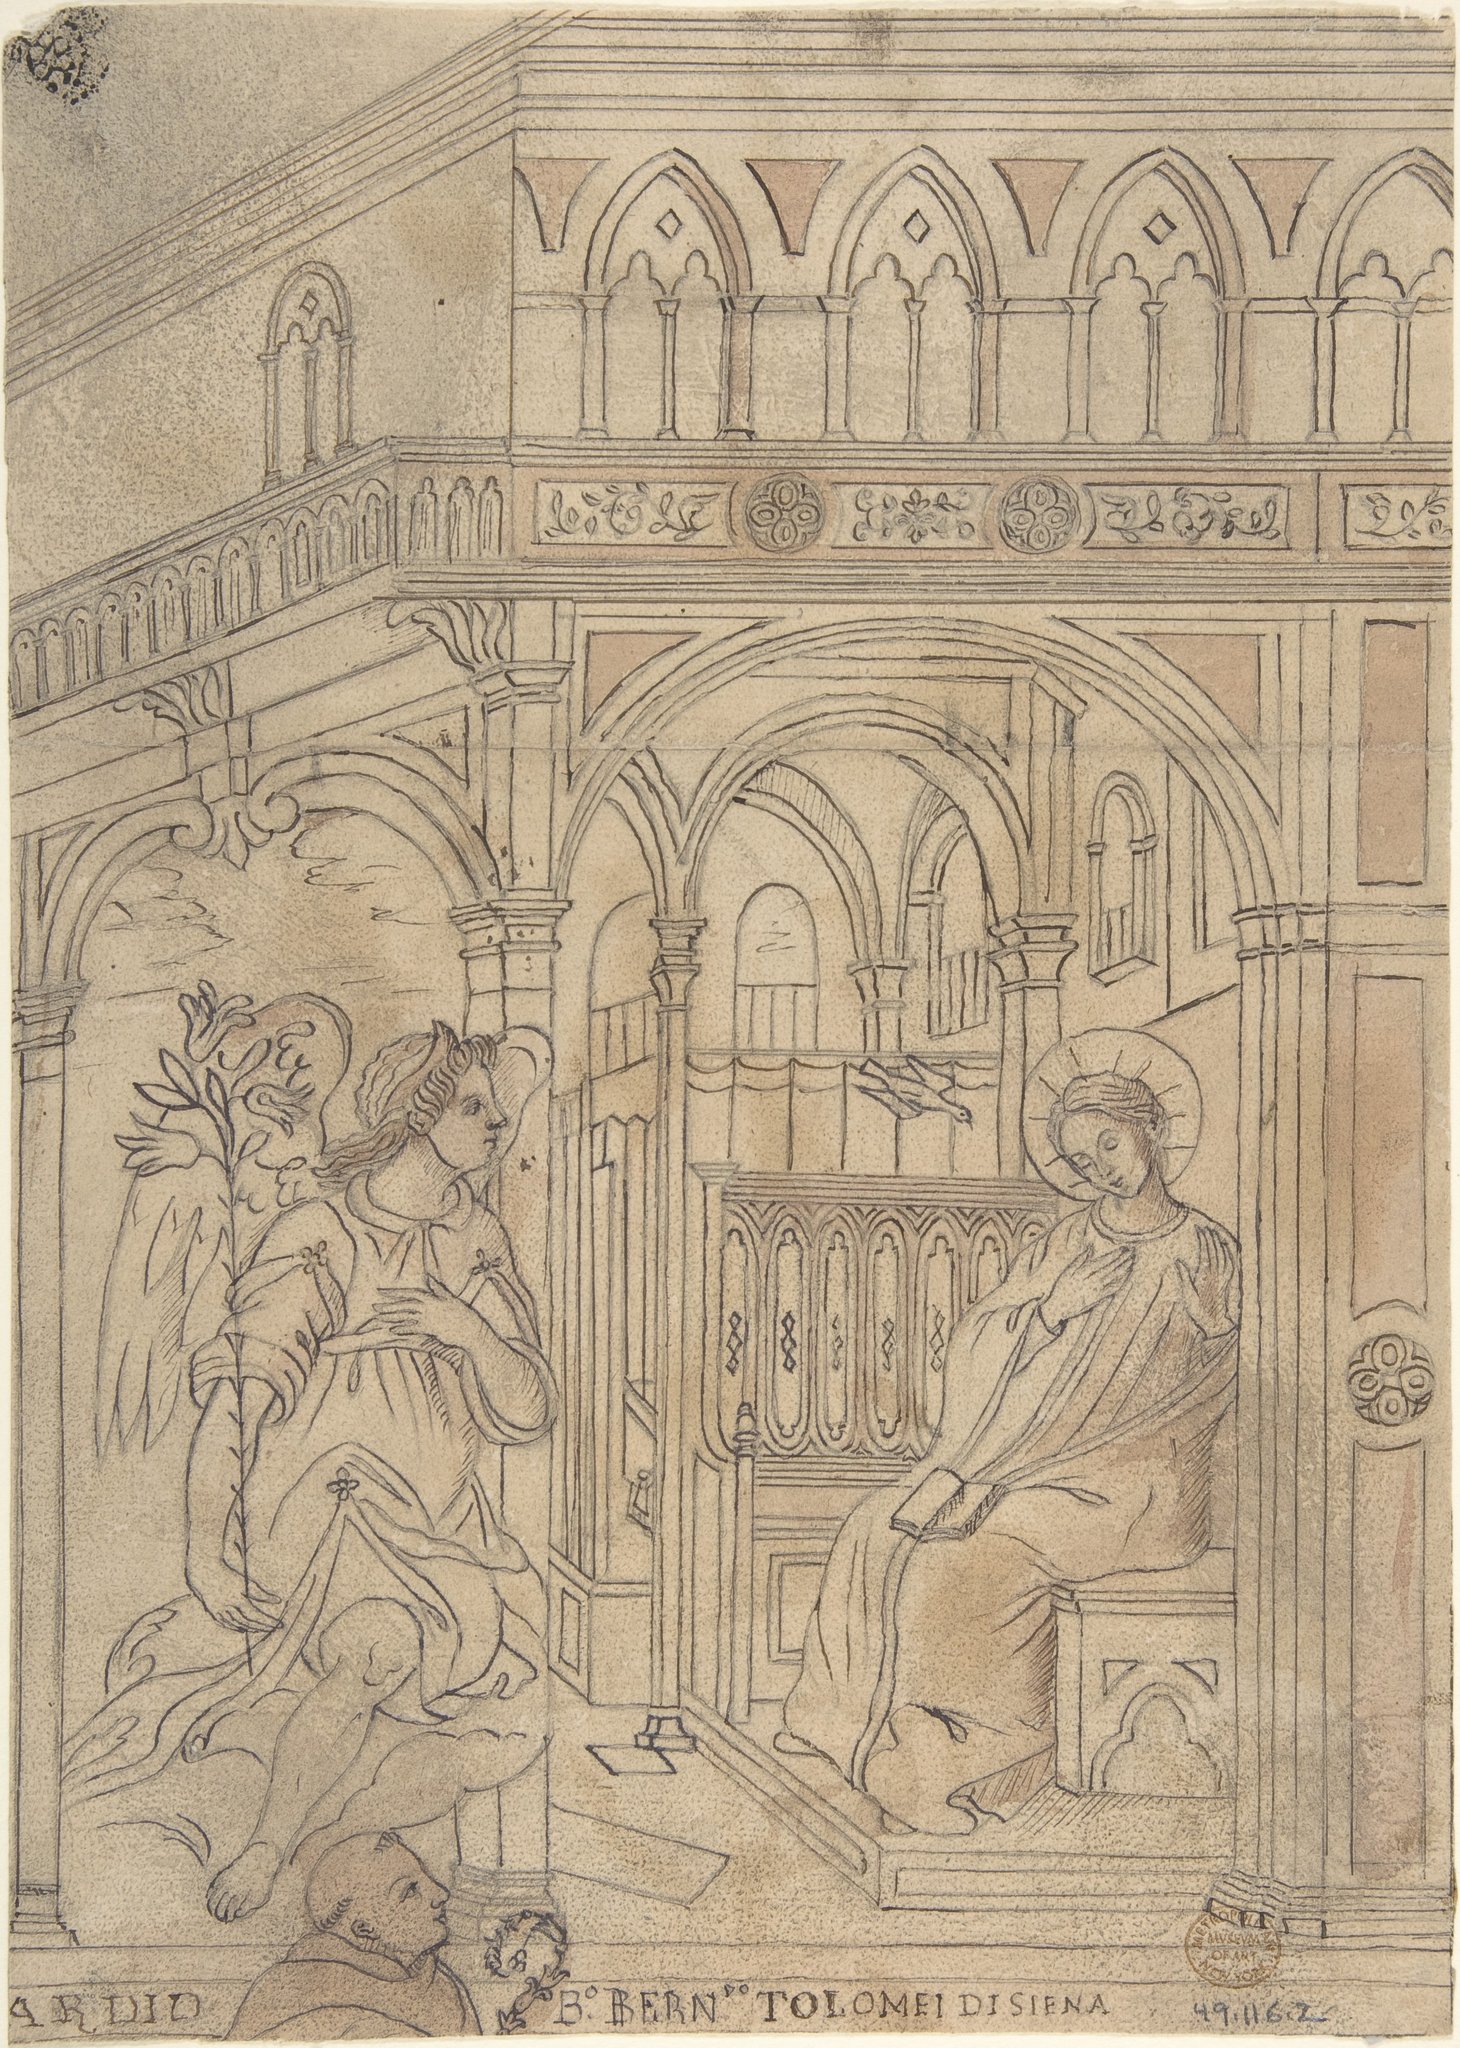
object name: drawing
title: Annunciation with Beato Bernardo Tolomei di Siena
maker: anonymous, italian, 19th century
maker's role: artist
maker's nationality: italian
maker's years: 1800-1900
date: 1801-1900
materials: chalk, graphite, ink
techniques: brush, incising, pen, wash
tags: annunciation